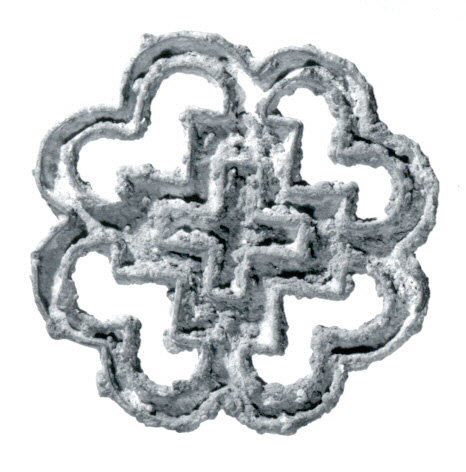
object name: stamp seal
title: Compartmented stamp seal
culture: bactria-margiana archaeological complex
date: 2333-1668 BCE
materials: copper alloy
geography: bactria-margiana